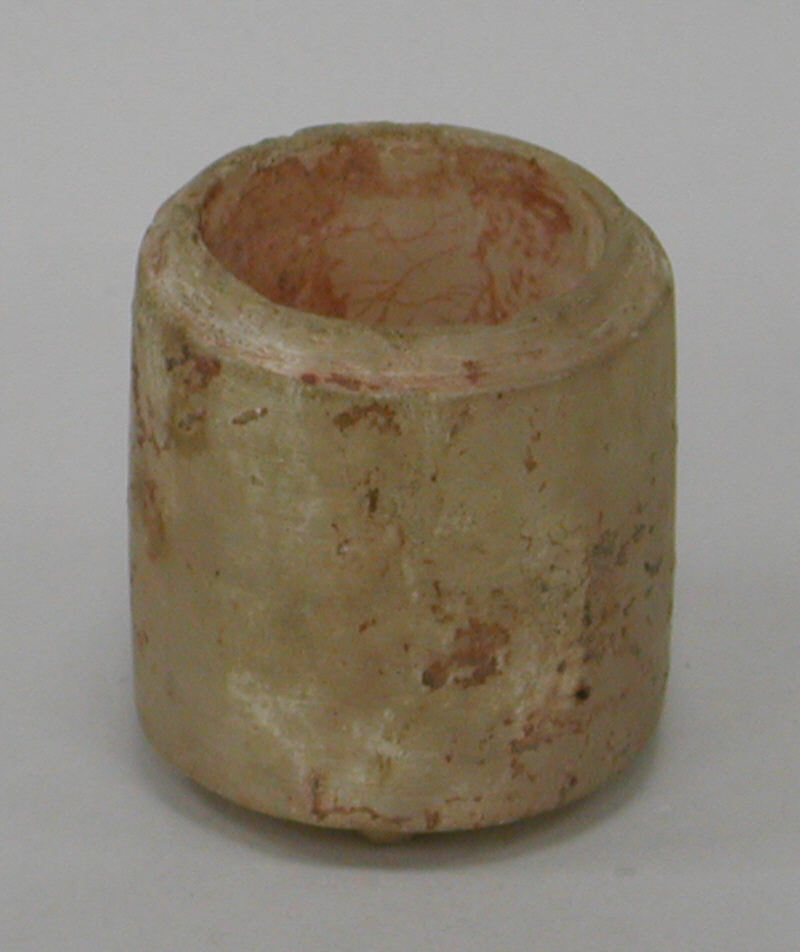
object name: vessel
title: Plain Onyx Vessel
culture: mexican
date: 1501-1600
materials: marble, onyx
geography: mexico